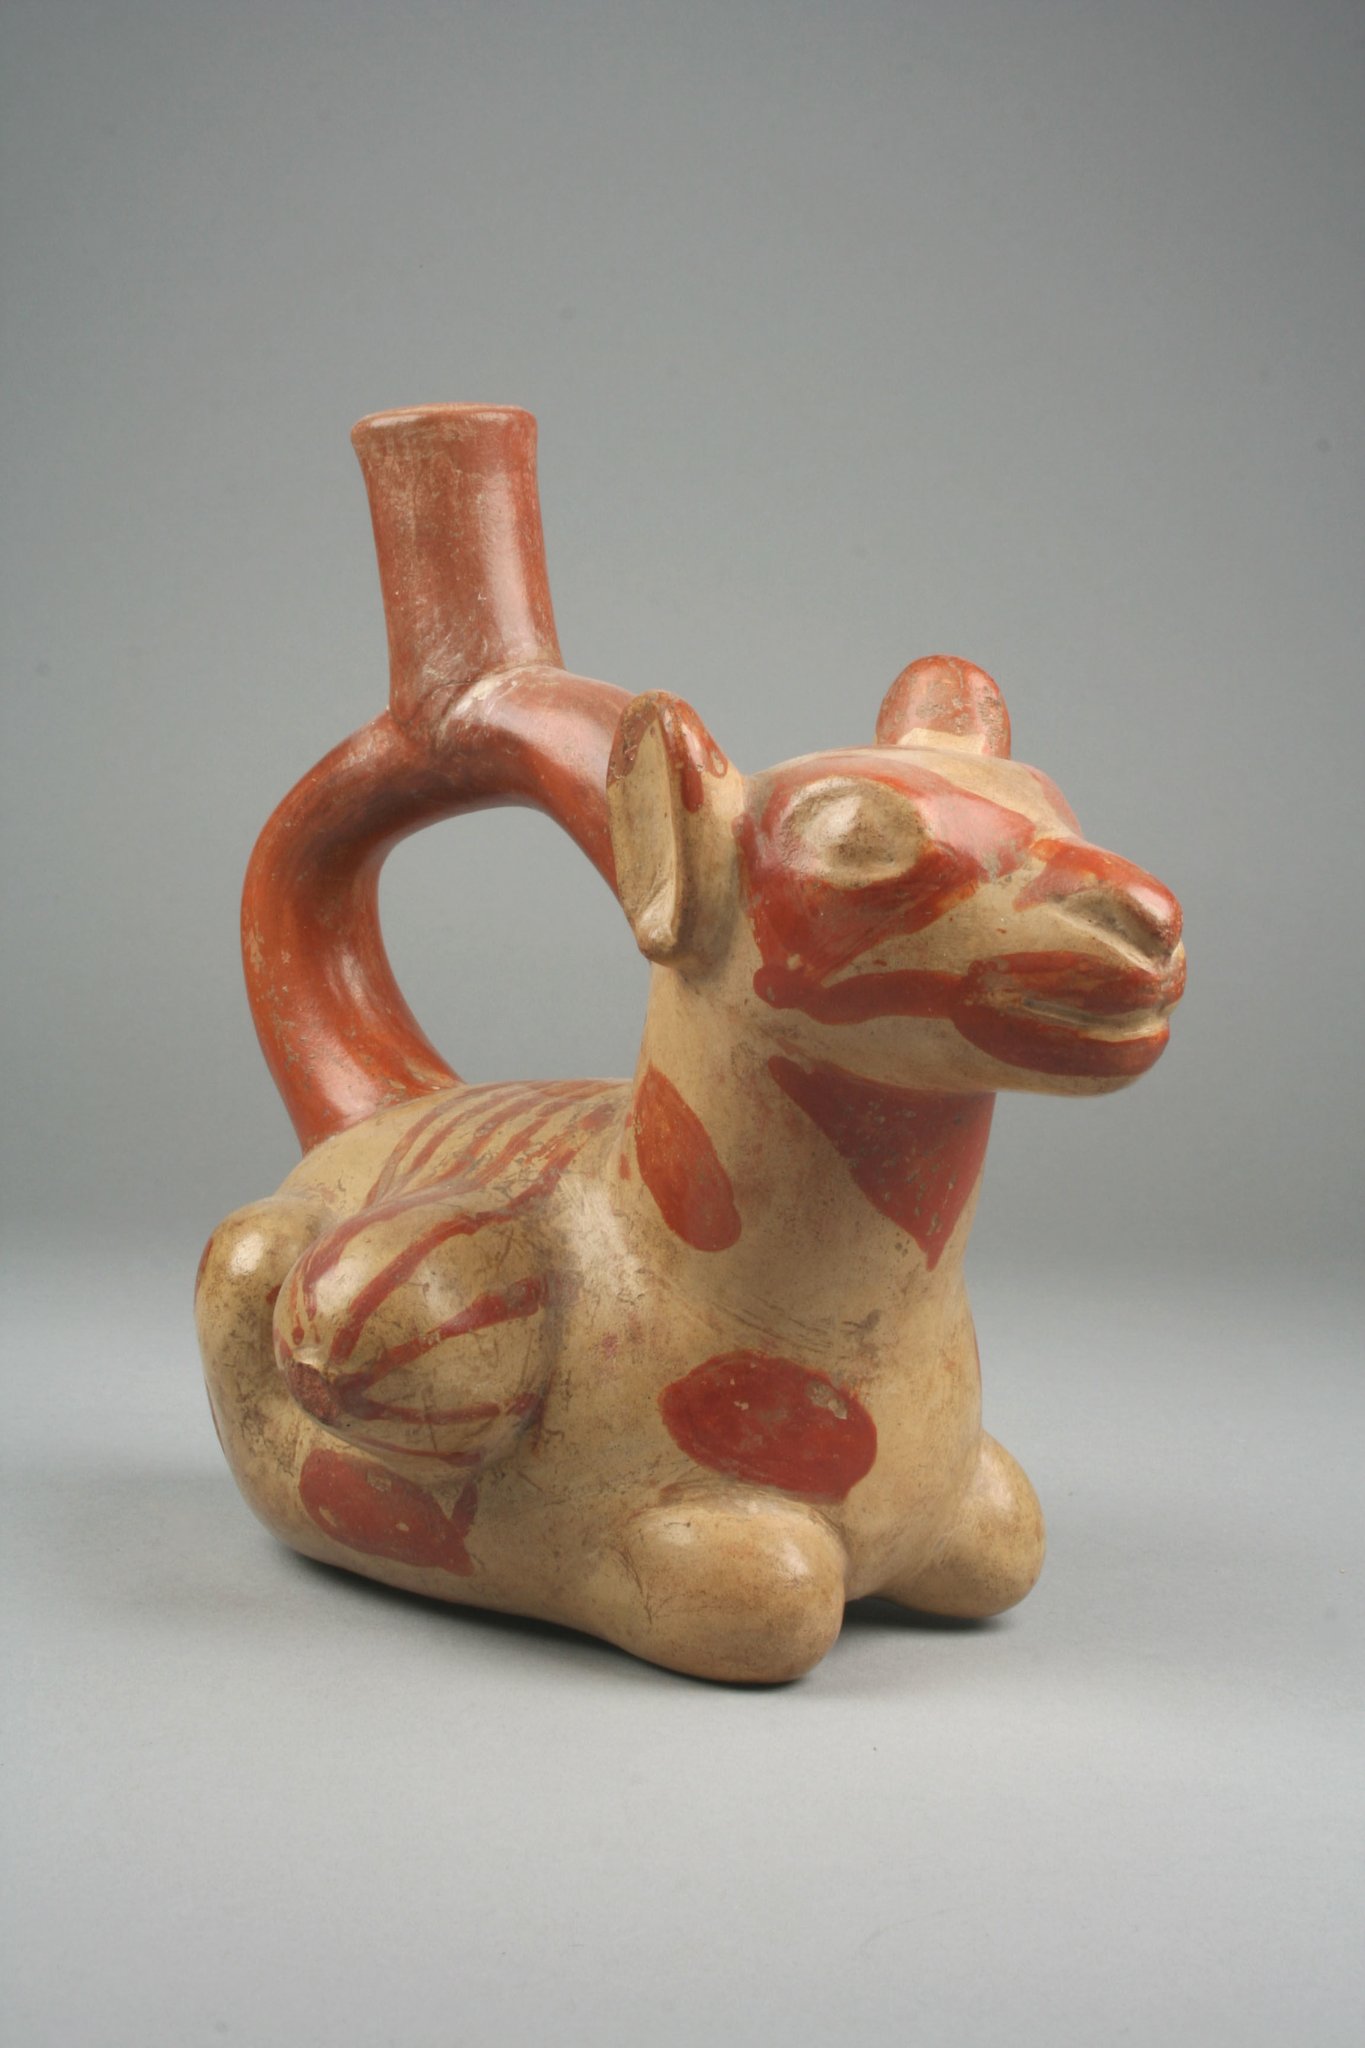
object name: bottle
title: Stirrup Spout Bottle with Reclining Llama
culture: moche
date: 1-600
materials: ceramic, pigment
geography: peru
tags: animals